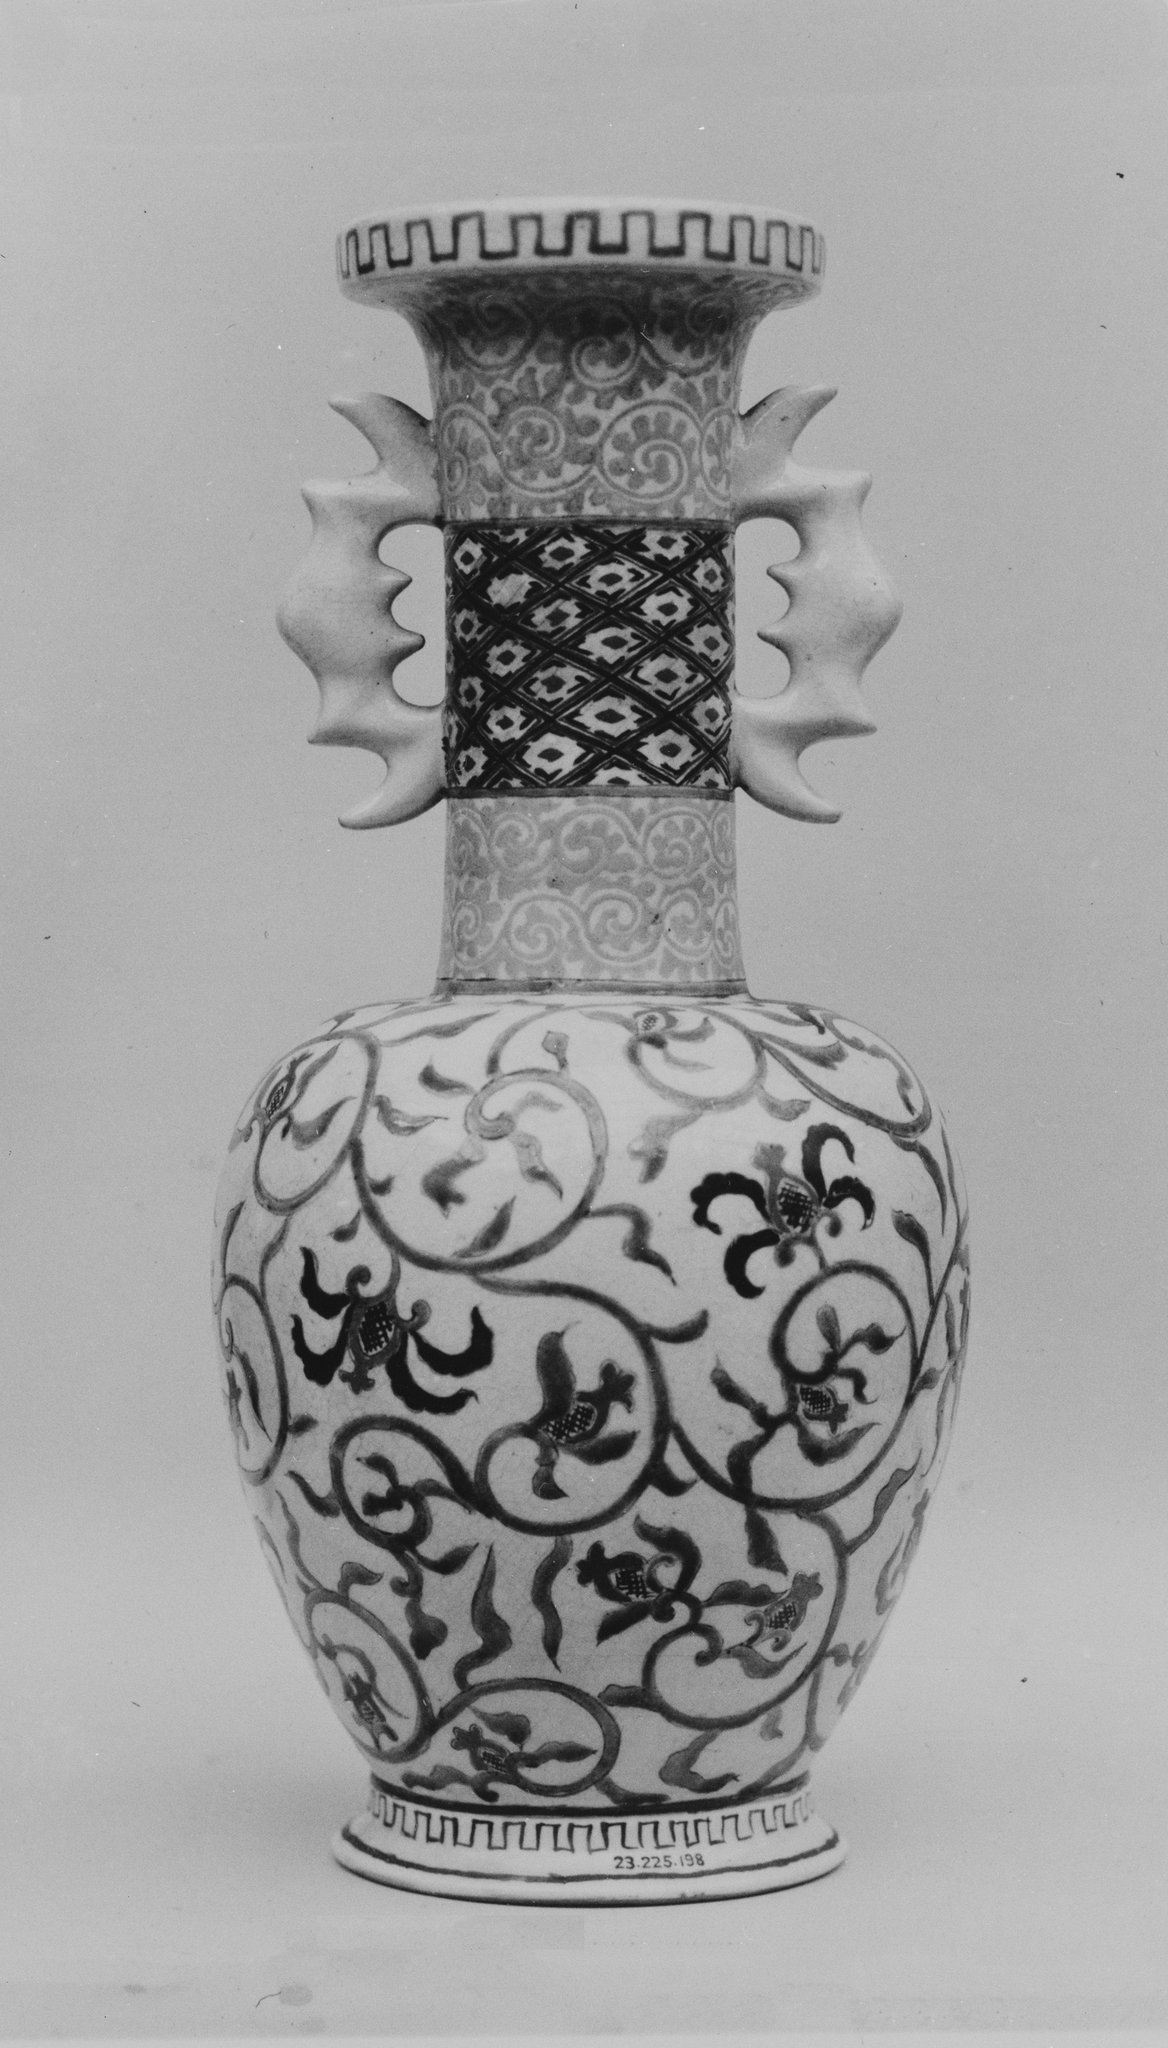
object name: vase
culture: japanese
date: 1840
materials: enamel, glaze, porcelain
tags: flowers